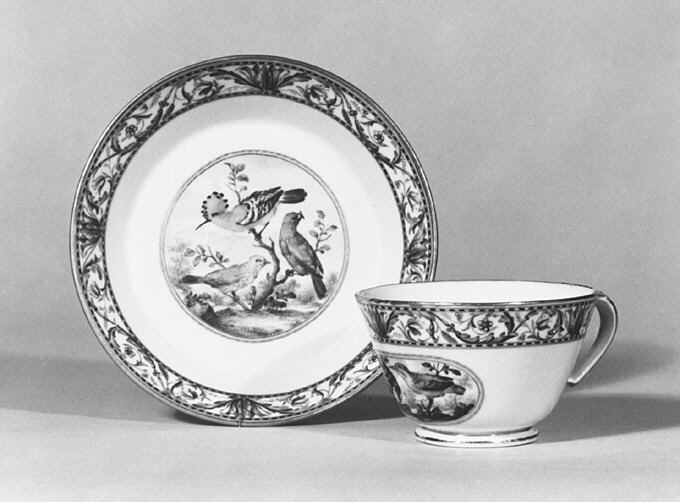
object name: teacup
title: Teacup (part of a service)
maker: meissen manufactory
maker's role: manufactory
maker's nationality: german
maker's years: 1710-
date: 1780-1785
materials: hard paste porcelain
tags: birds,flowers